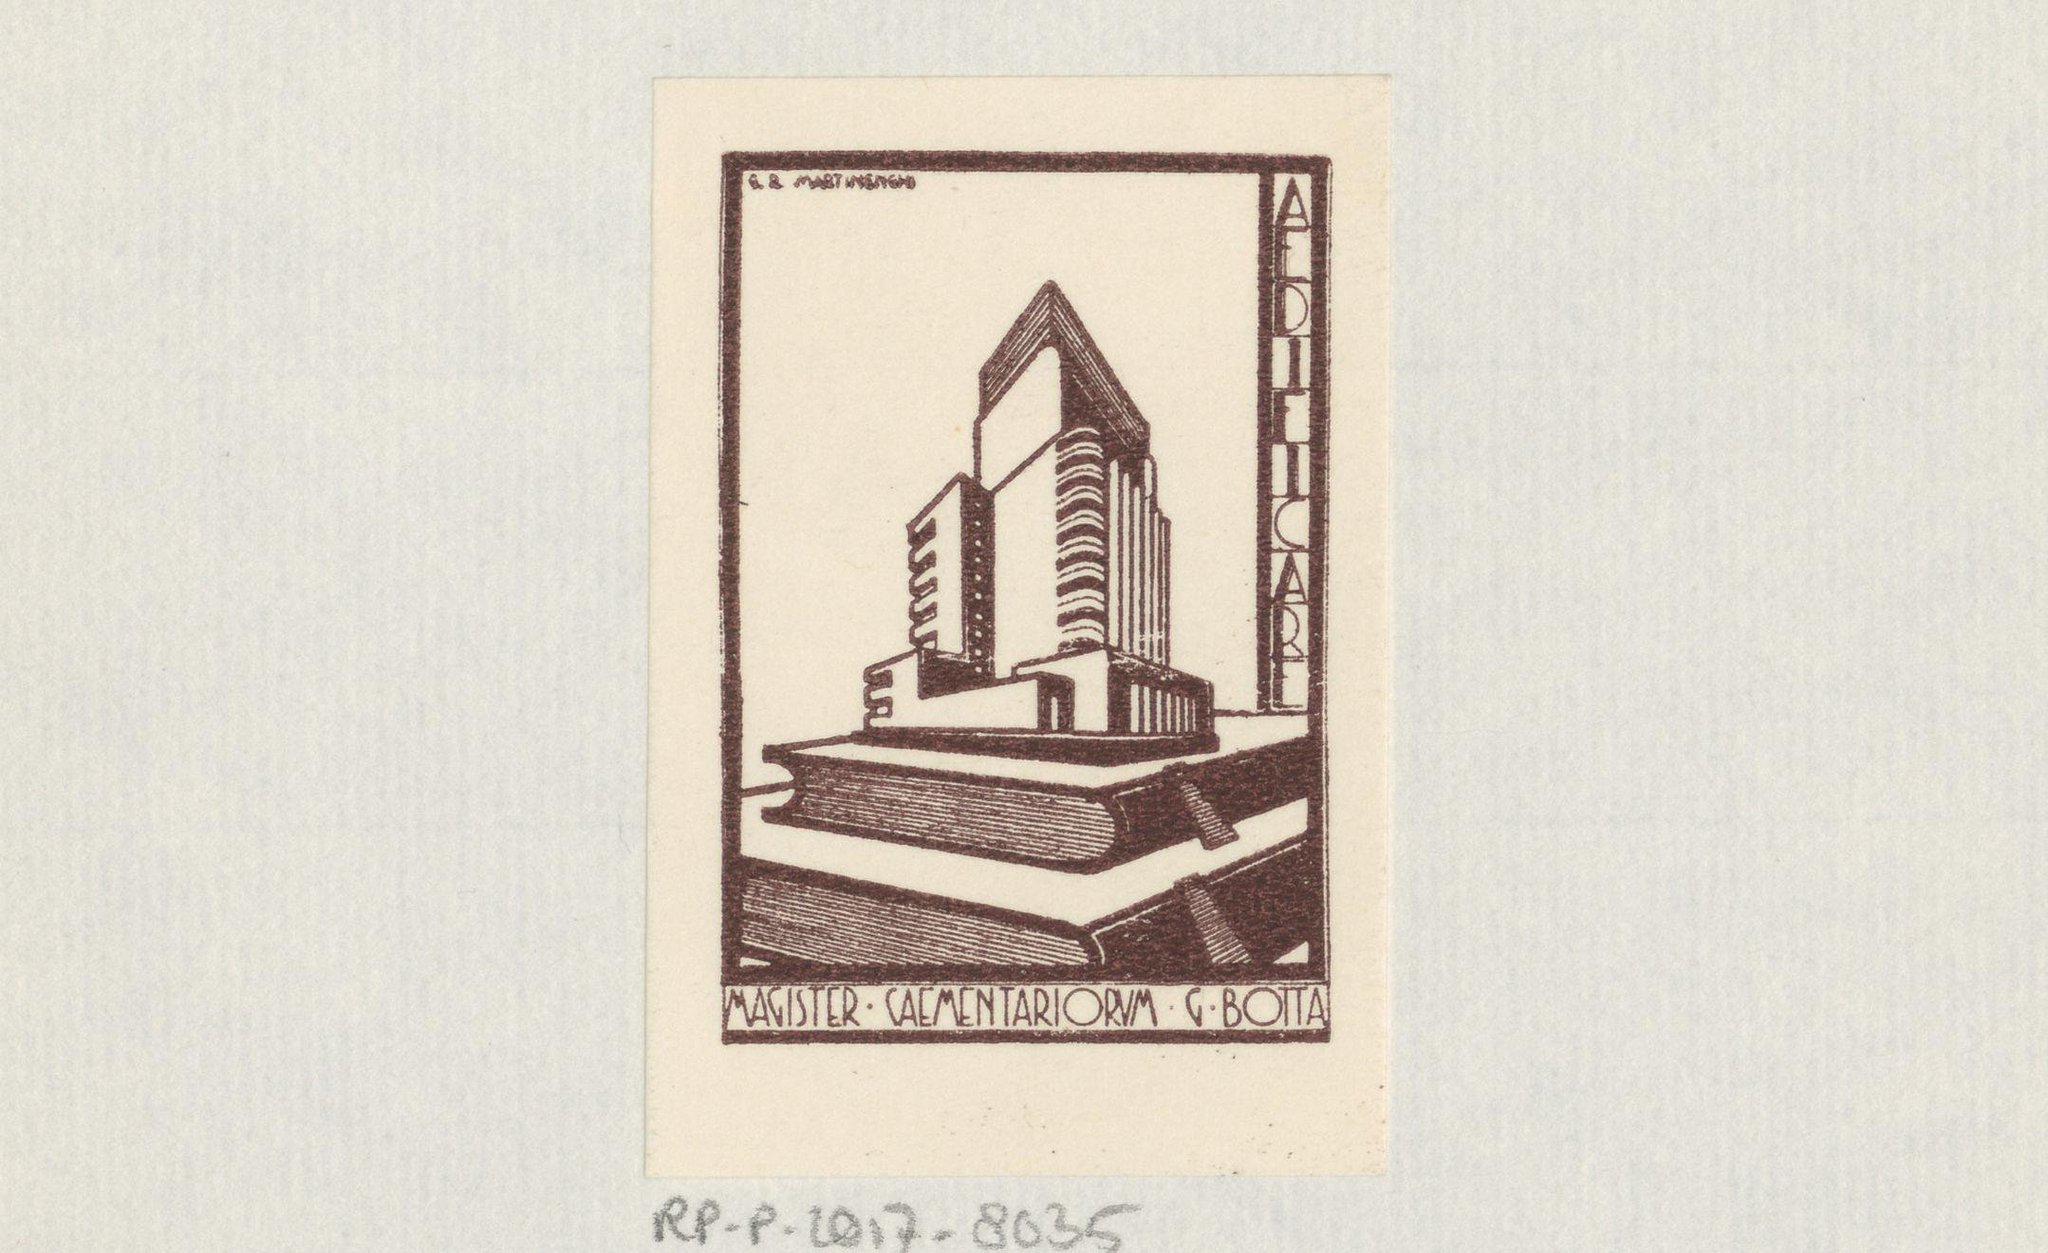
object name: bookplate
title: Ex libris van G. Botta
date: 1916-1988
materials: paper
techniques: printing block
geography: italy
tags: housing, book